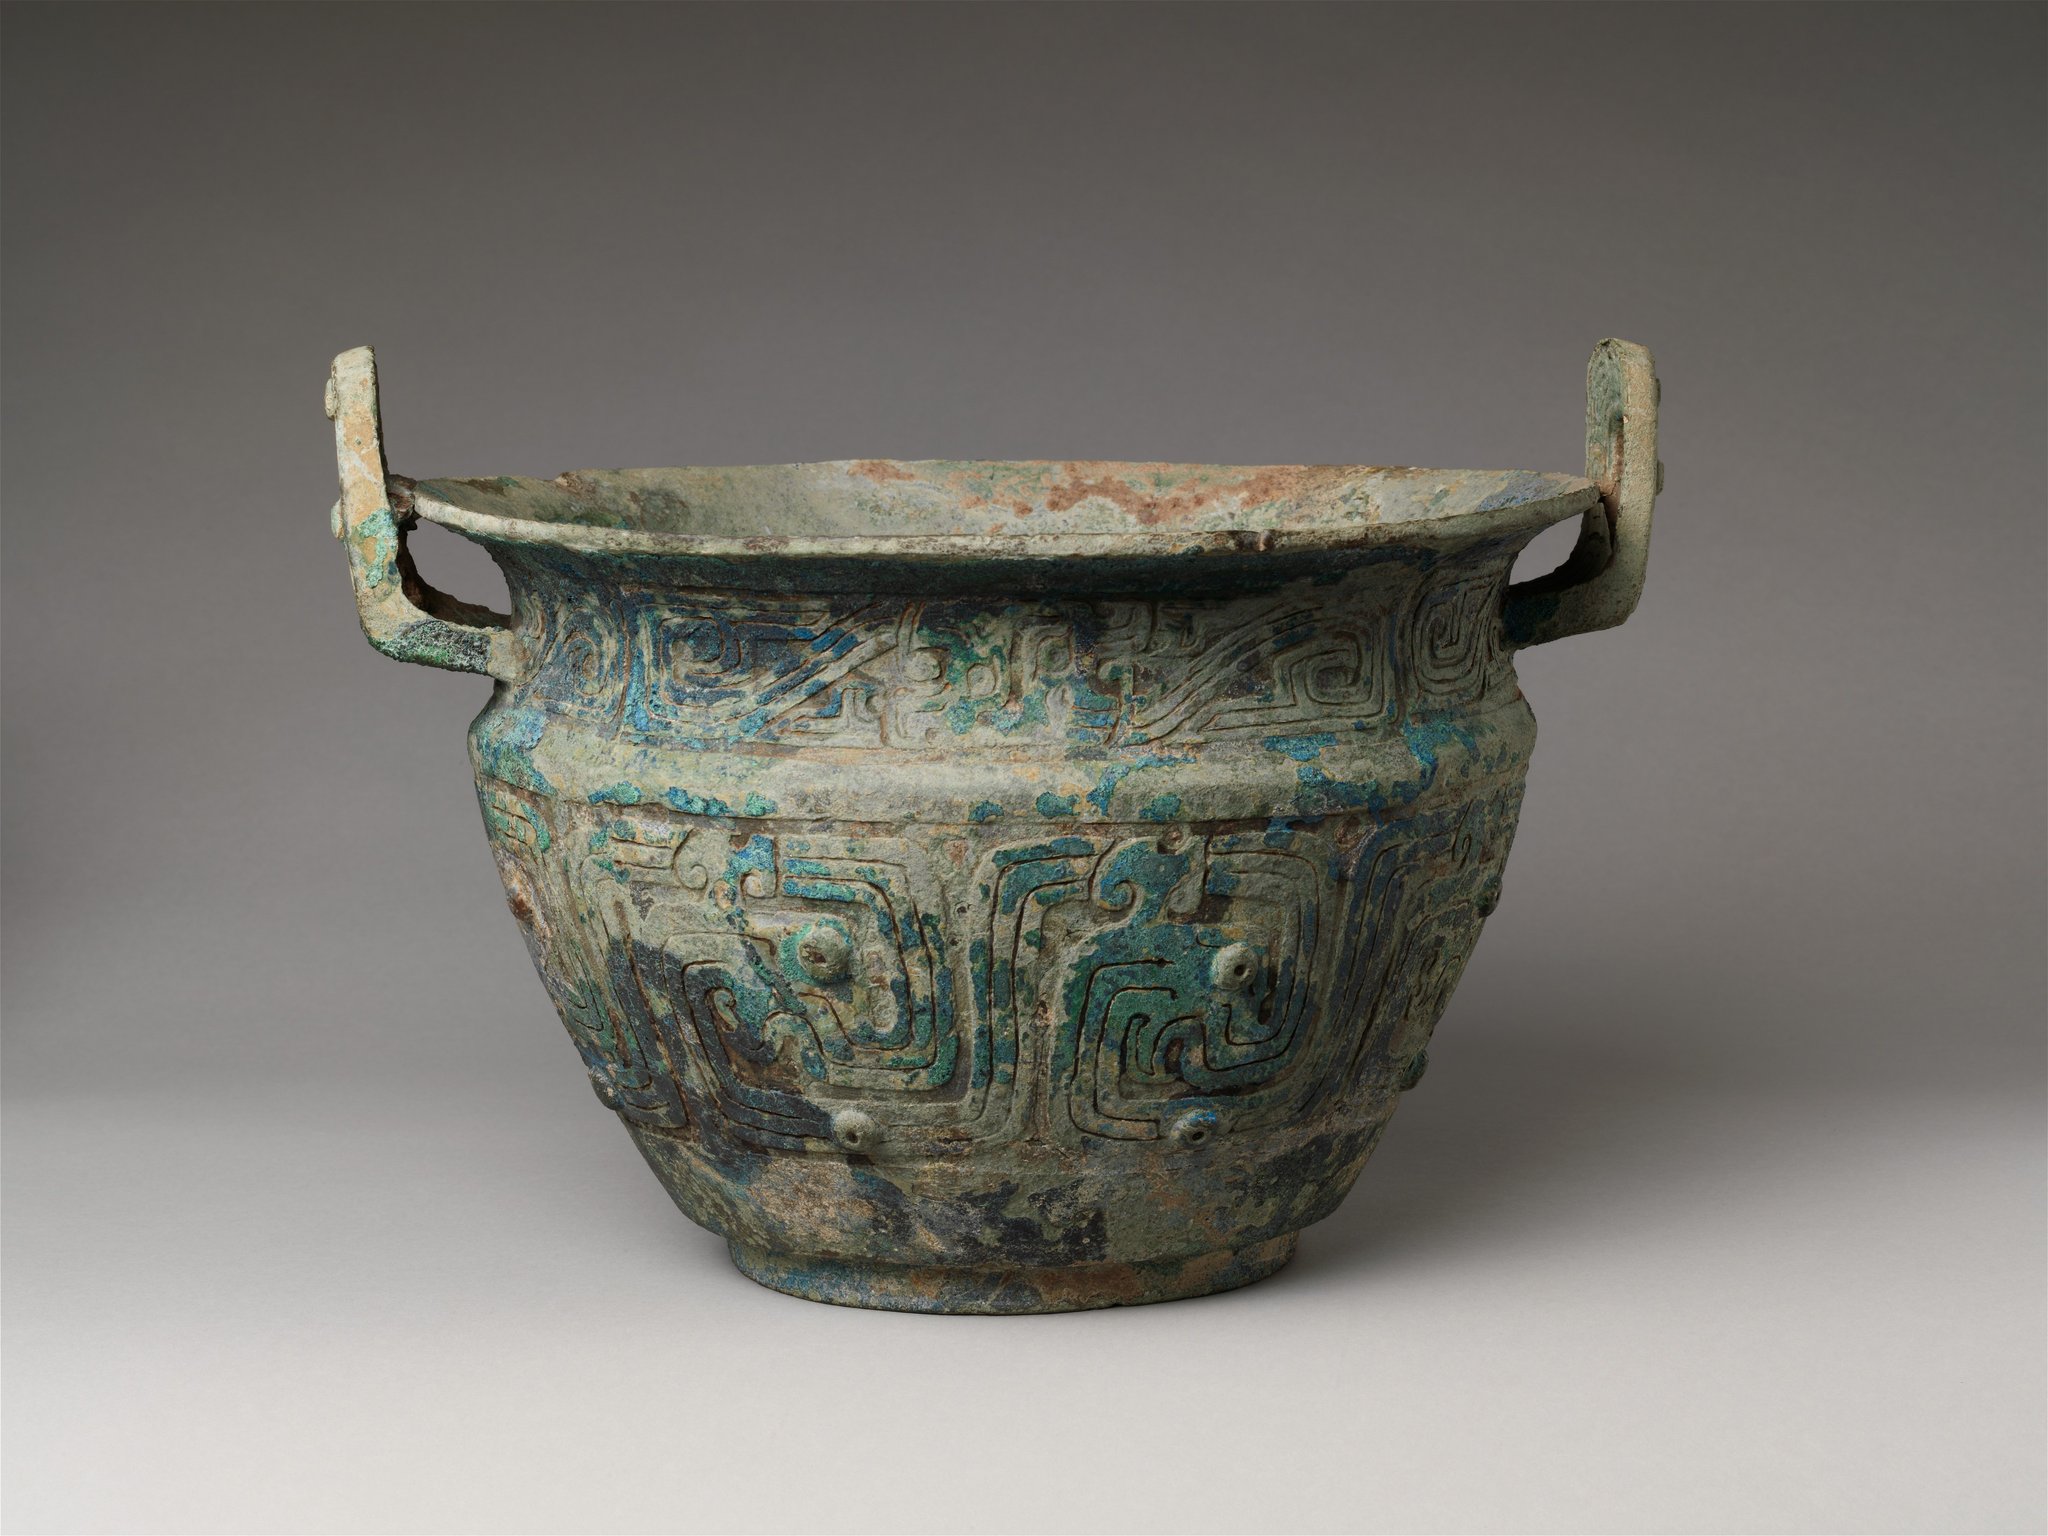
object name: steamer part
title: Part of a steamer (Zeng)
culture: chinese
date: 834-768 BCE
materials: bronze